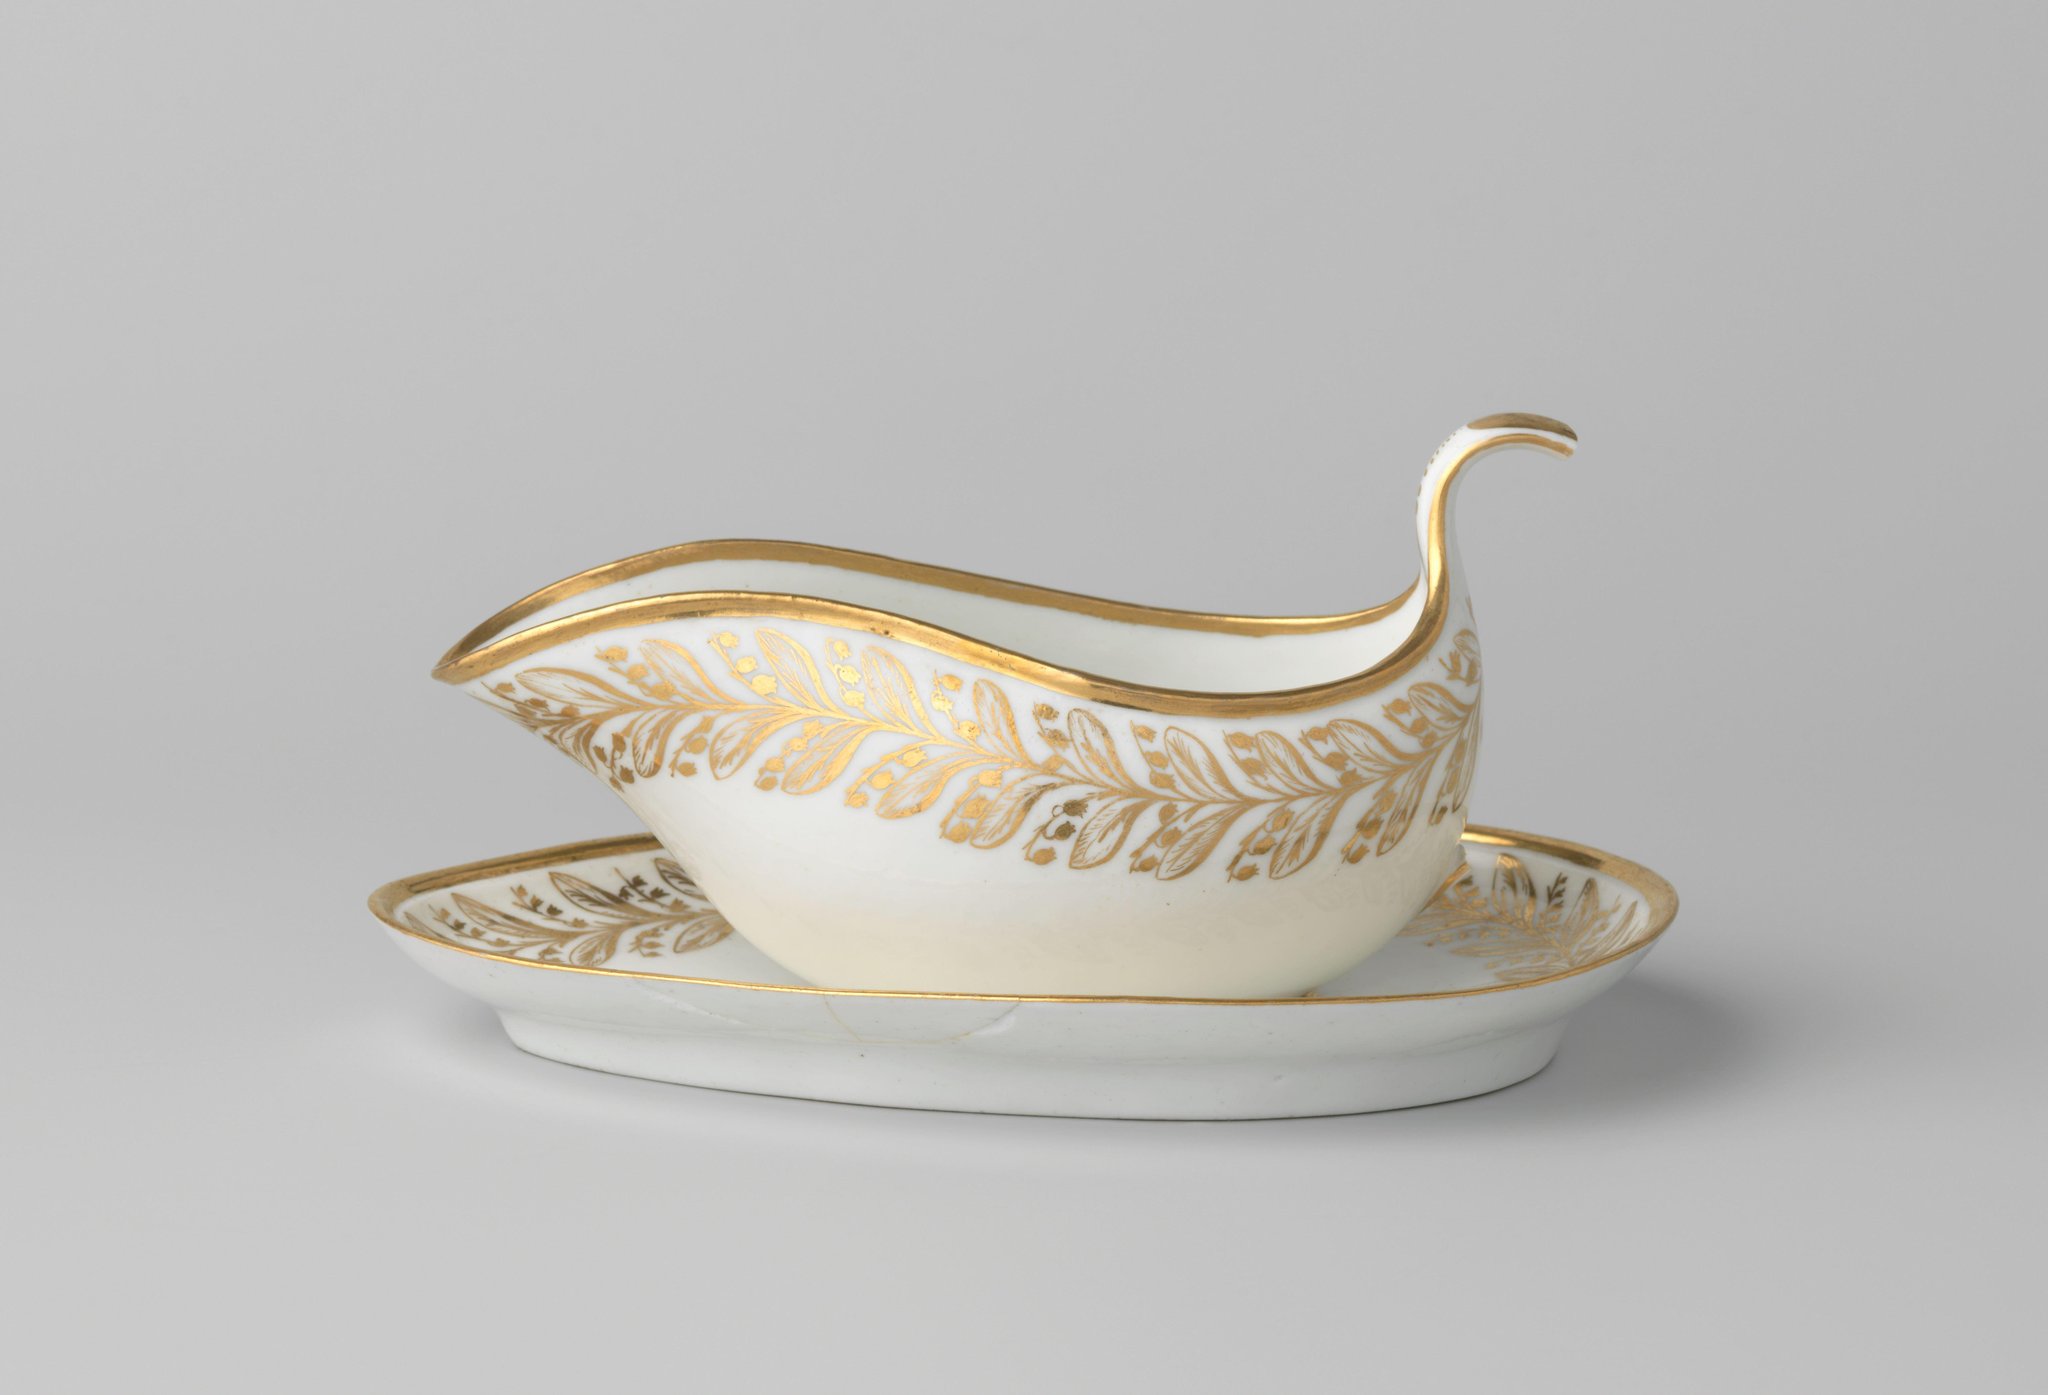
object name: sauceboat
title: Sauce bowl with dish with the coat of arms of Hendrik Peter Godfried Quack and Isabella Gertraud von Carnap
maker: Anonymous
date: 1790-1800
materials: glaze, gold, paint, porcelain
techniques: firing, forming, gilding, turning, vitrification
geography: low countries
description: Ovale sauskom met schotel van porselein, beschilderd op het glazuur met goud. Op het plat van de schotel het alliantiewapen van Hendrik Peter Godfried Quack en Isabella Gertraud von Carnap. De binnenwand met een bloemrank en een gouden band op de rand. Drie proenen op de onderzijde. De buitenrand van de kom met een bloemrank en een gouden band op de rand en voet. Rand van de schotel beschadigd; oor van de sauskom ontbreekt.